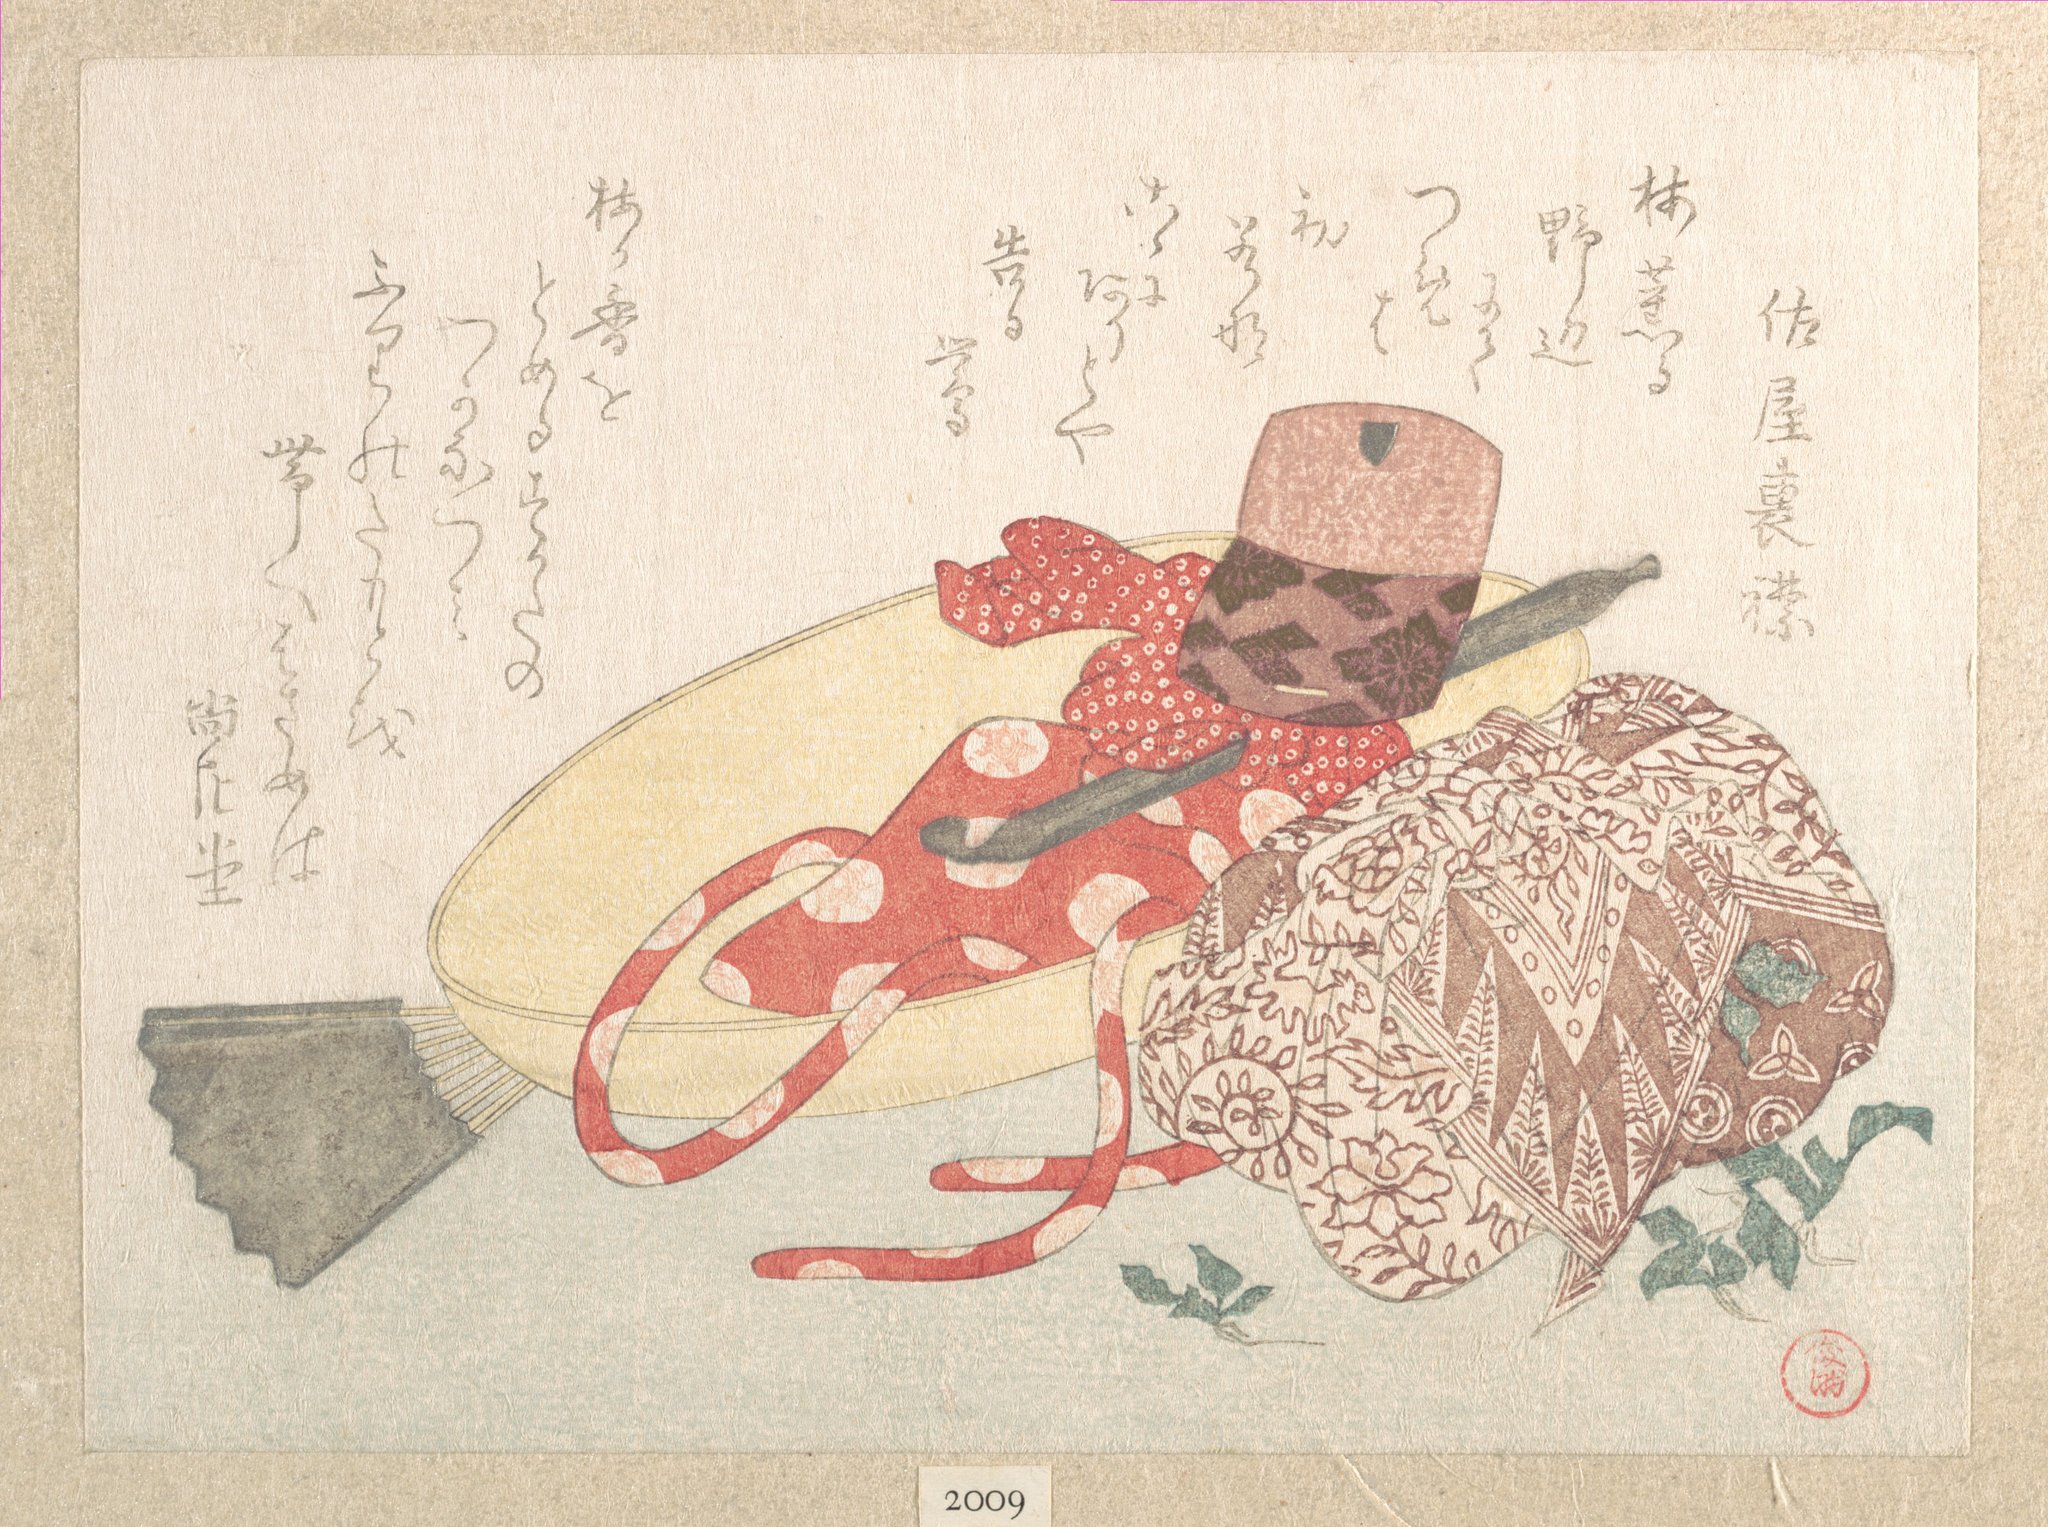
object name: print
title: Picnic Outfit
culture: japanese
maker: kubo shunman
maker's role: artist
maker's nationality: japanese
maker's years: 1757-1820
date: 1801-1900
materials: ink, paper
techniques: surimono, woodblock print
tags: fans,clothing